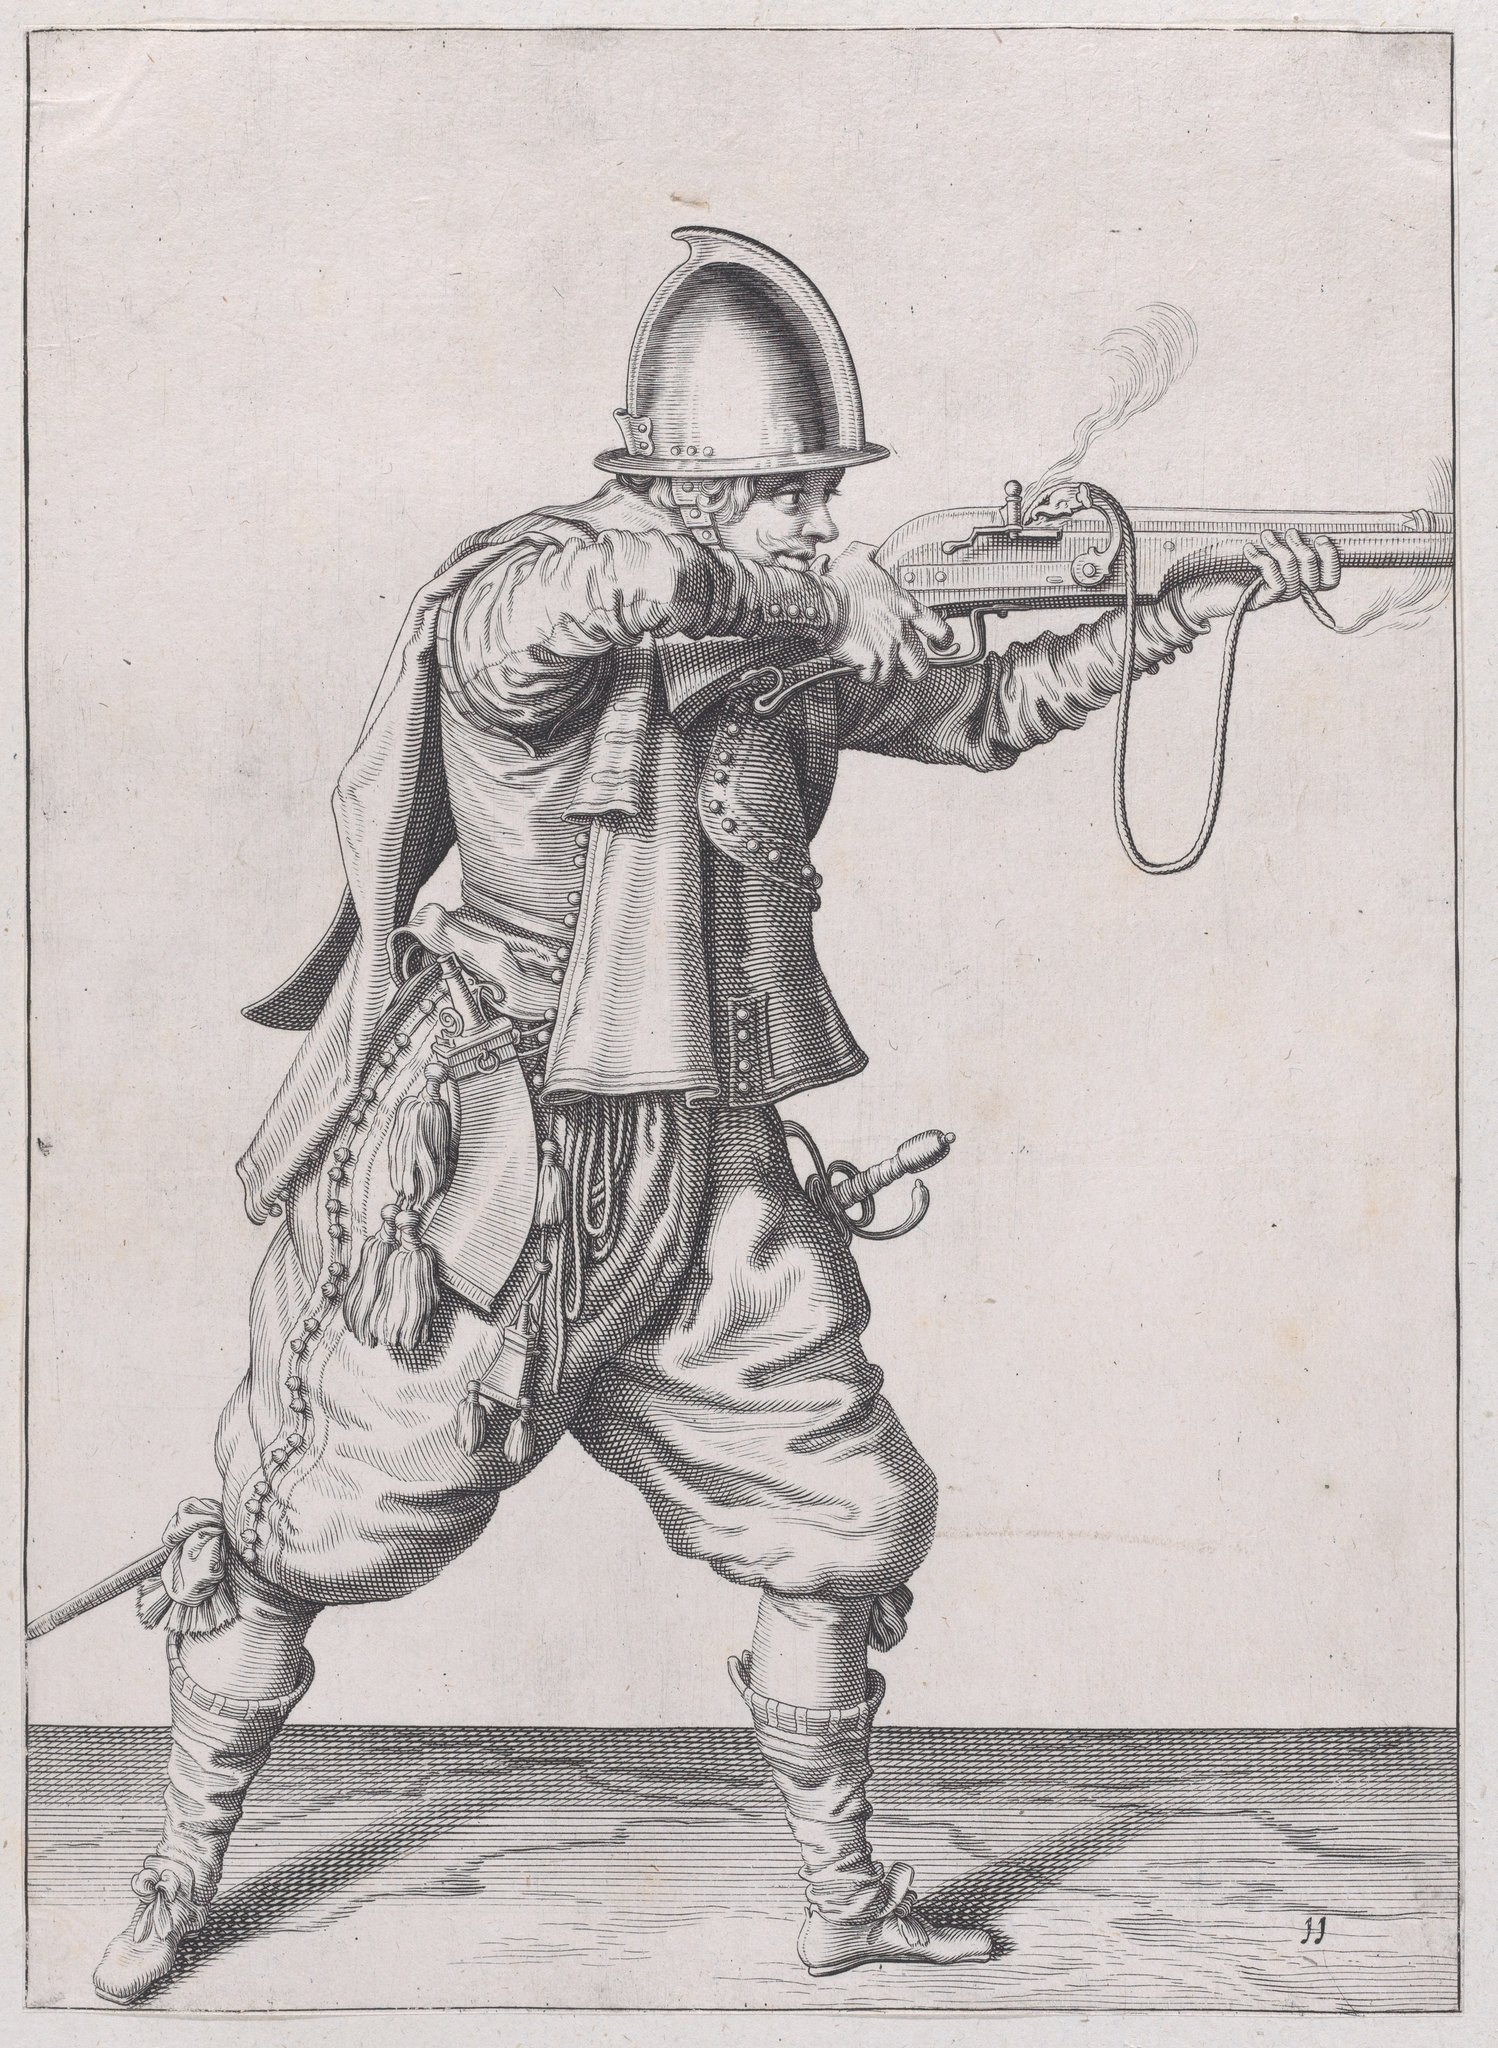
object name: print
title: A soldier taking aim, from the Marksmen series, plate 11, in Waffenhandlung von den Rören Musquetten undt Spiessen / Wapenhandelinghe van Roers Musquetten ende Spiessen (The Exercise of Arms)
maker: jacques de gheyn (ii)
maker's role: artist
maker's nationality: netherlandish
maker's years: 1565-1629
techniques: engraving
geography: the hague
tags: soldiers,firearms,men